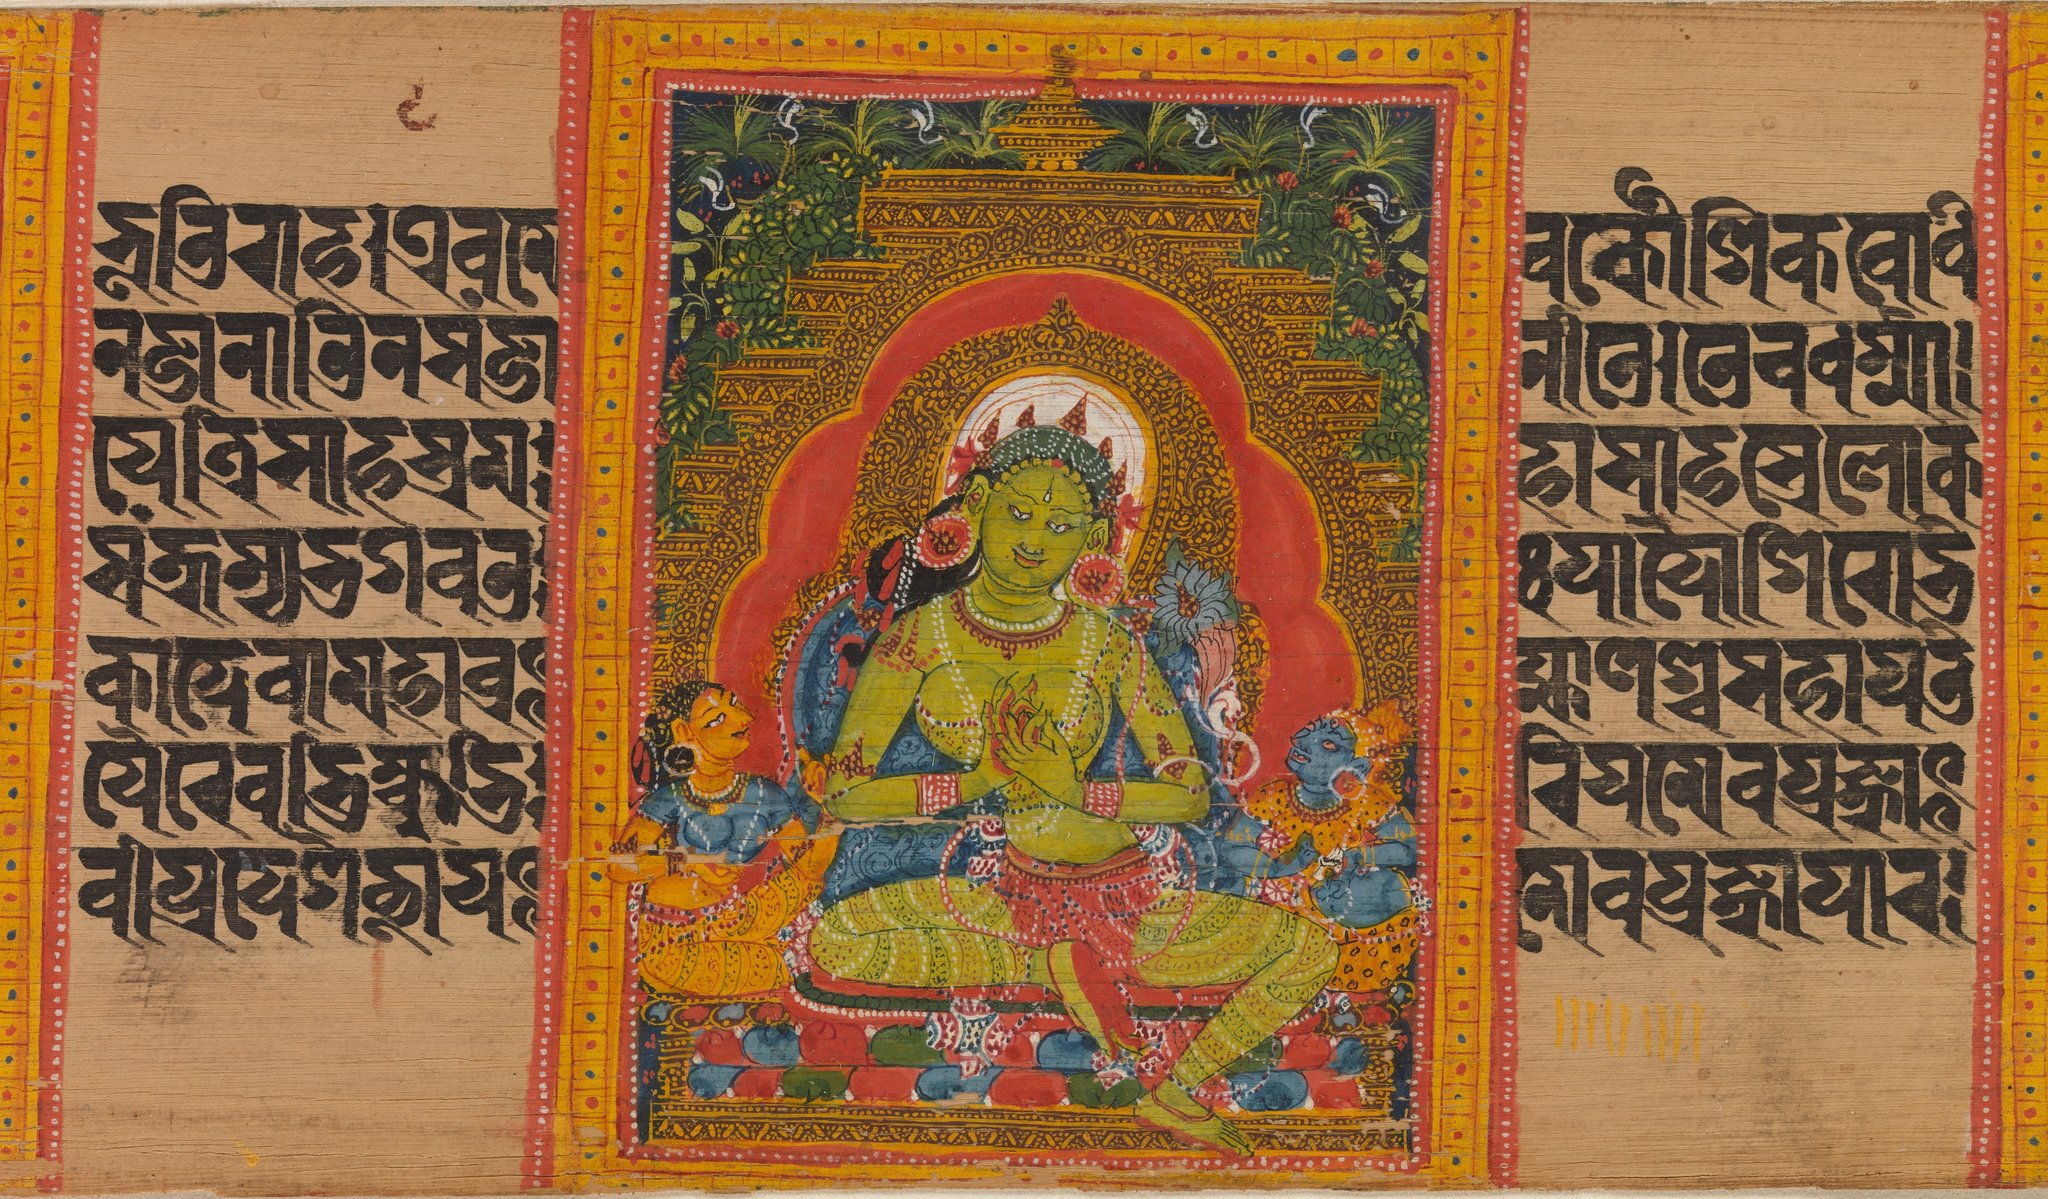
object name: folio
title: Green Tara, Folio from a dispersed Ashtasahasrika Prajnaparamita (Perfection of Wisdom) Manuscript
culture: indian, bengal or bangladesh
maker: mahavihara master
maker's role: artist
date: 1101-1133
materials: leaf, watercolor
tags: buddhism,bodhisattvas